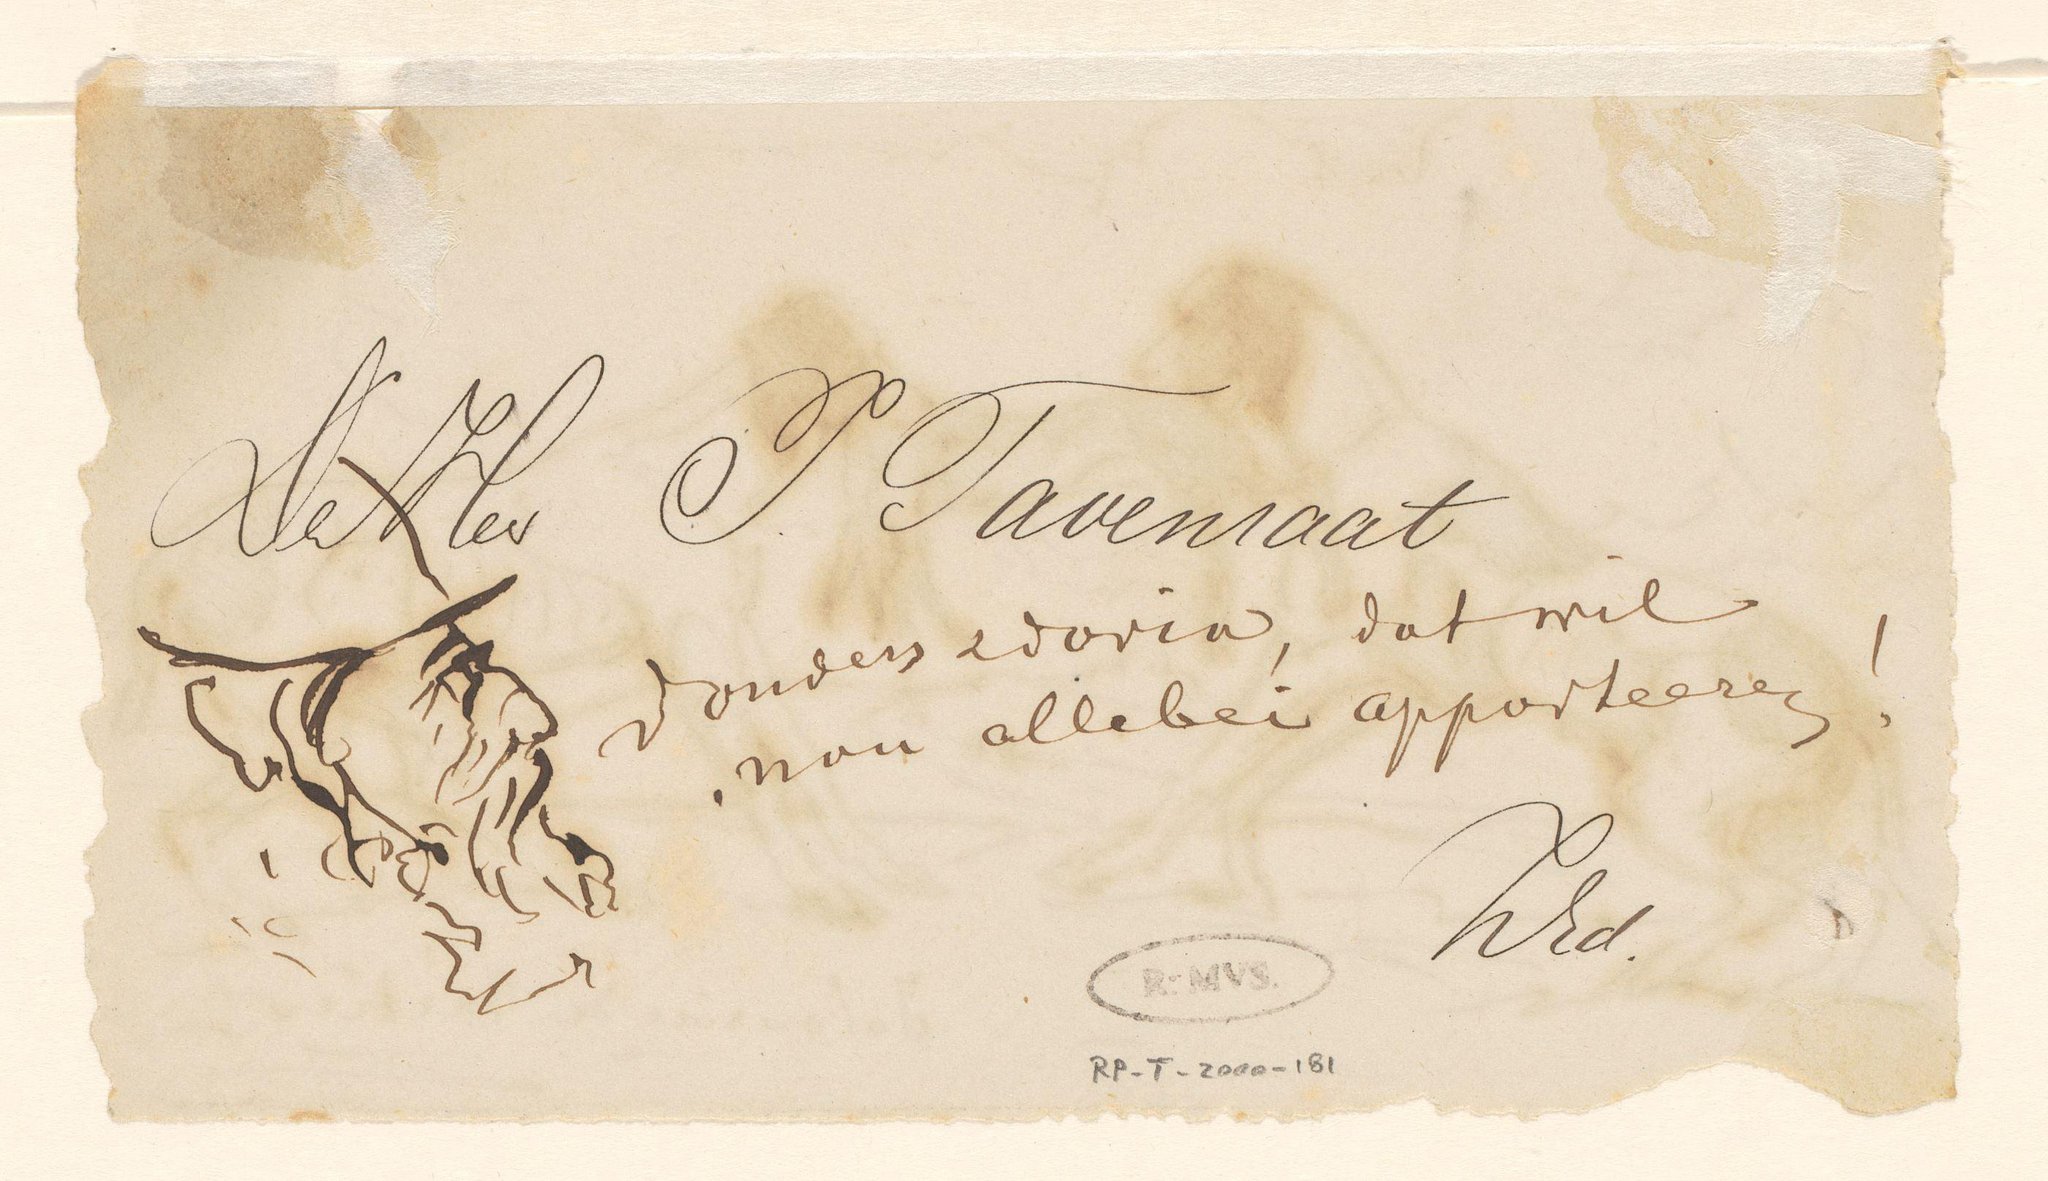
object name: drawing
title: Kop met baard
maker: johannes tavenraat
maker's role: draughtsman, painter, print maker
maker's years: 1809-1881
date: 1840-1880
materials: ink, paper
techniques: pen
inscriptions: annotation: ‘De Heer J Tavenraat / donders ... , dat wil nou allebei apporteeren!’, collector's mark: Lugt 2228